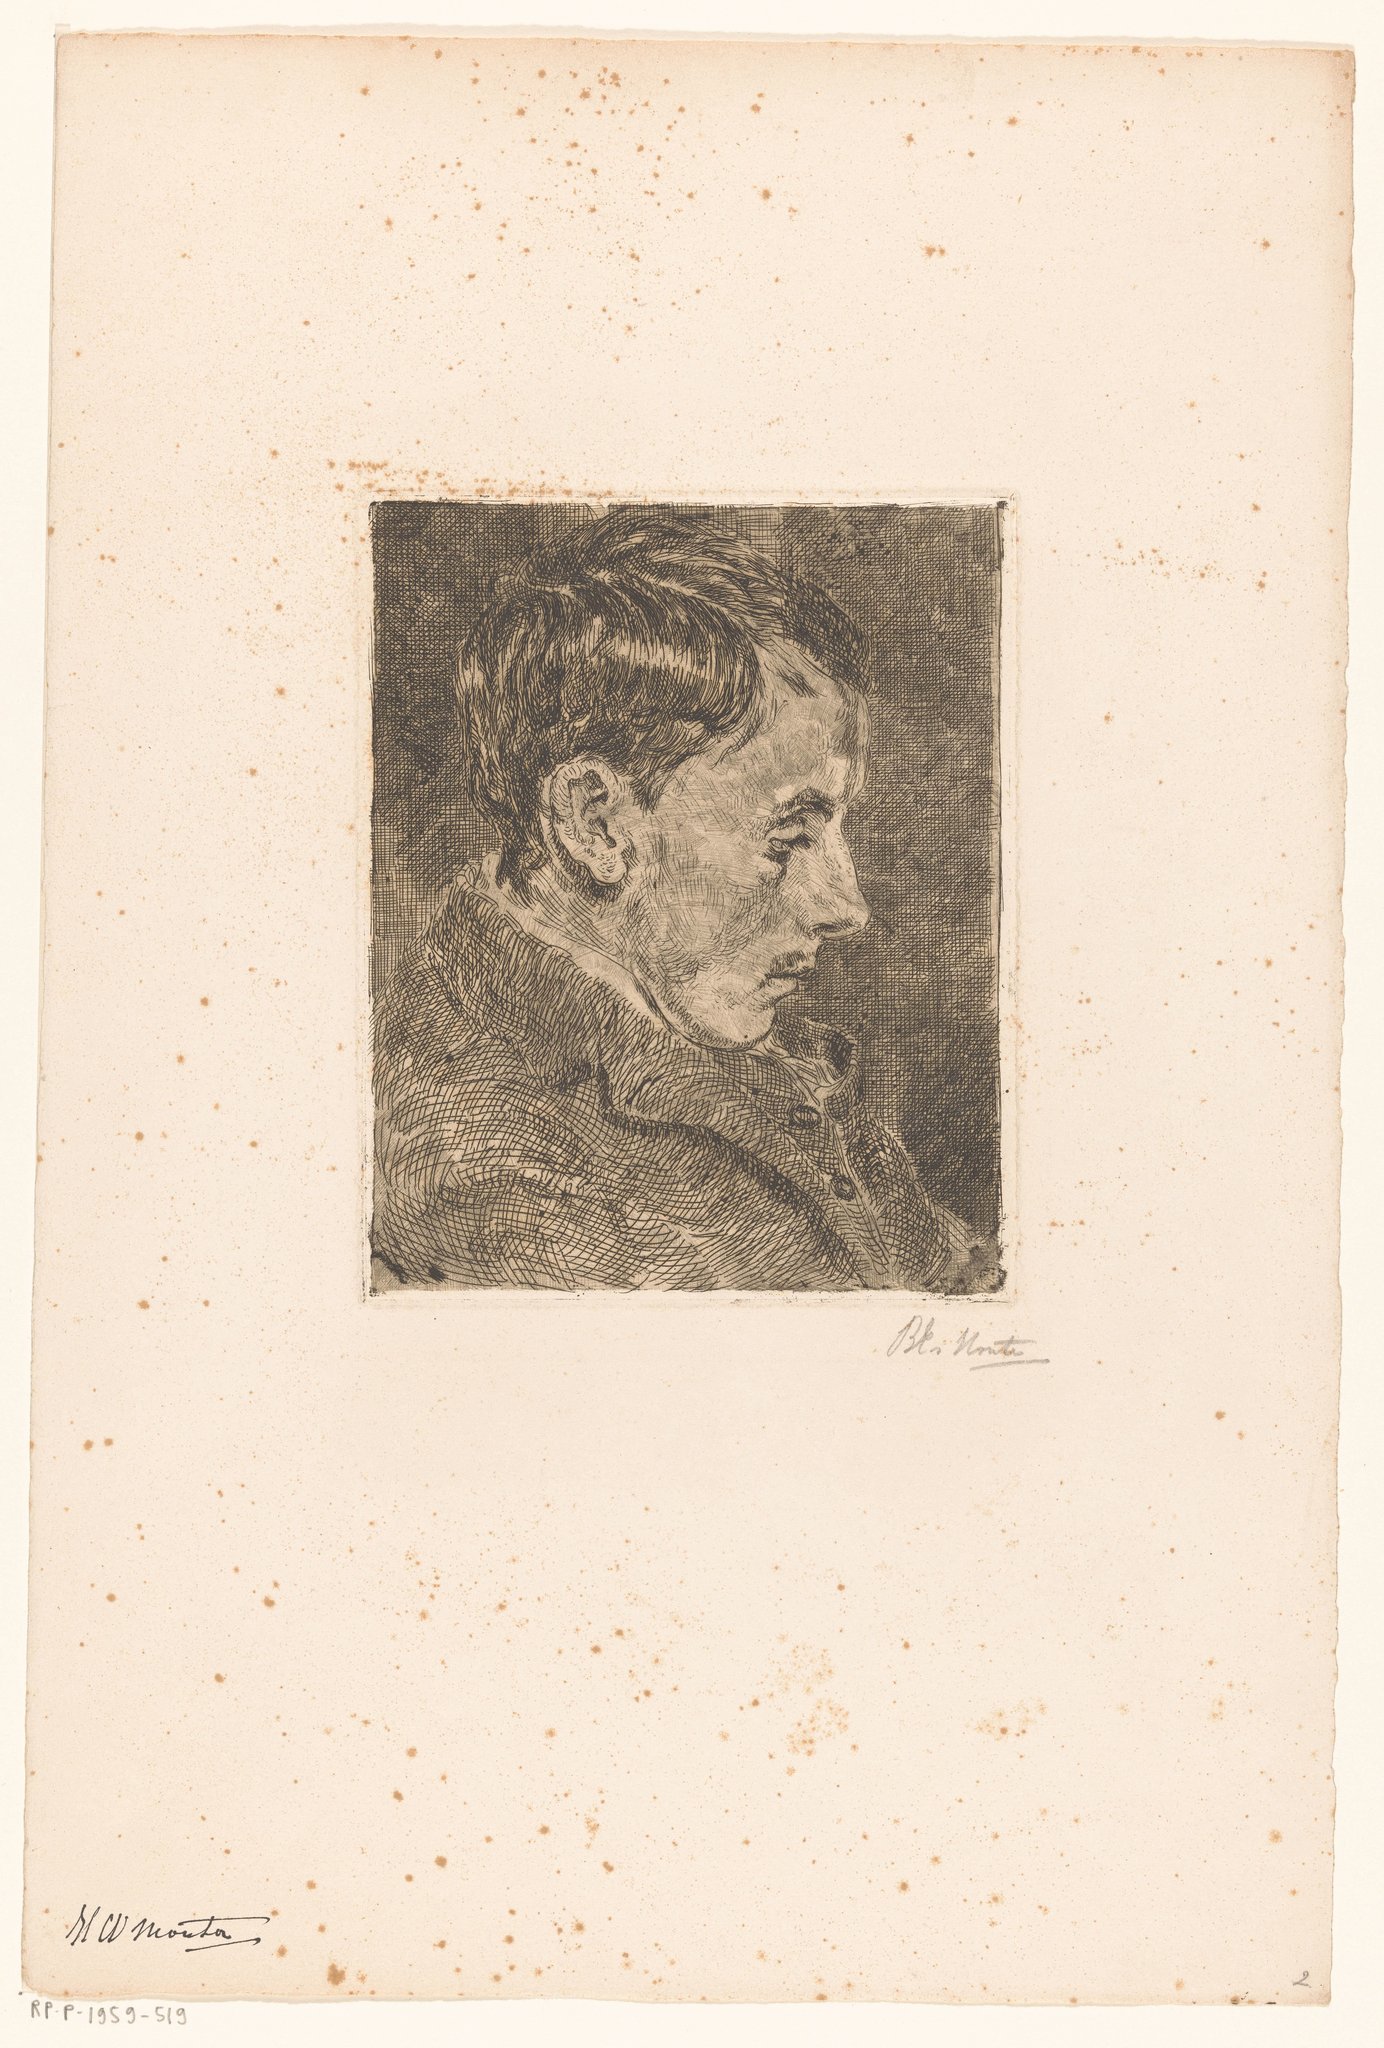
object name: print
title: Portret van Hendrik Willem Mouton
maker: barbara elisabeth van houten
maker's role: draughtsman, print maker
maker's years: 1862-1950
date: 1872-1950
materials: paper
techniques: etching, intaglio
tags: official, historical persons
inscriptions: collector's mark: Lugt 2228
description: Hendrik Willem Mouton was een zoon van Wilhelmina Theodora van Houten, een zus van Barbara Elisabeth van Houten.